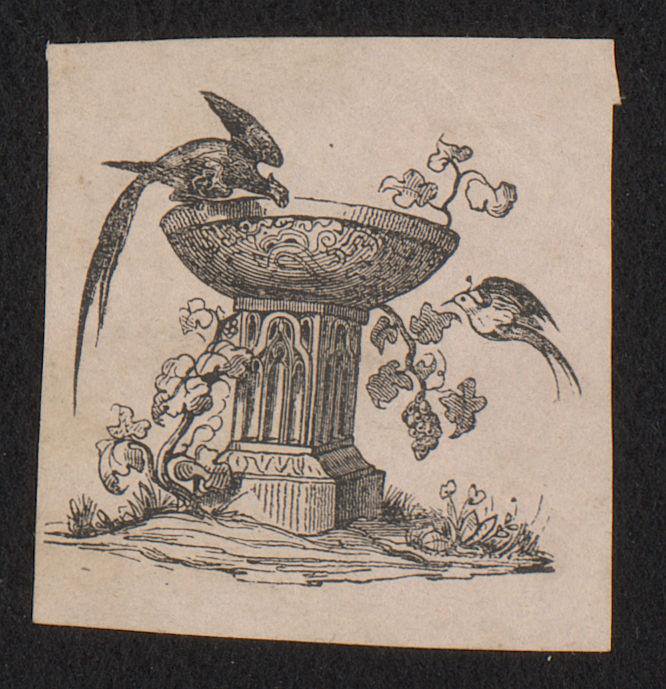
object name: print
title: Twee siervogels bij een sokkel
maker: isaac weissenbruch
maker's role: print maker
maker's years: 1826-1912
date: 1836-1912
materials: paper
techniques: engraving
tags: ornamental birds, pedestal of a piece of sculpture (perhaps in the form of a herm)